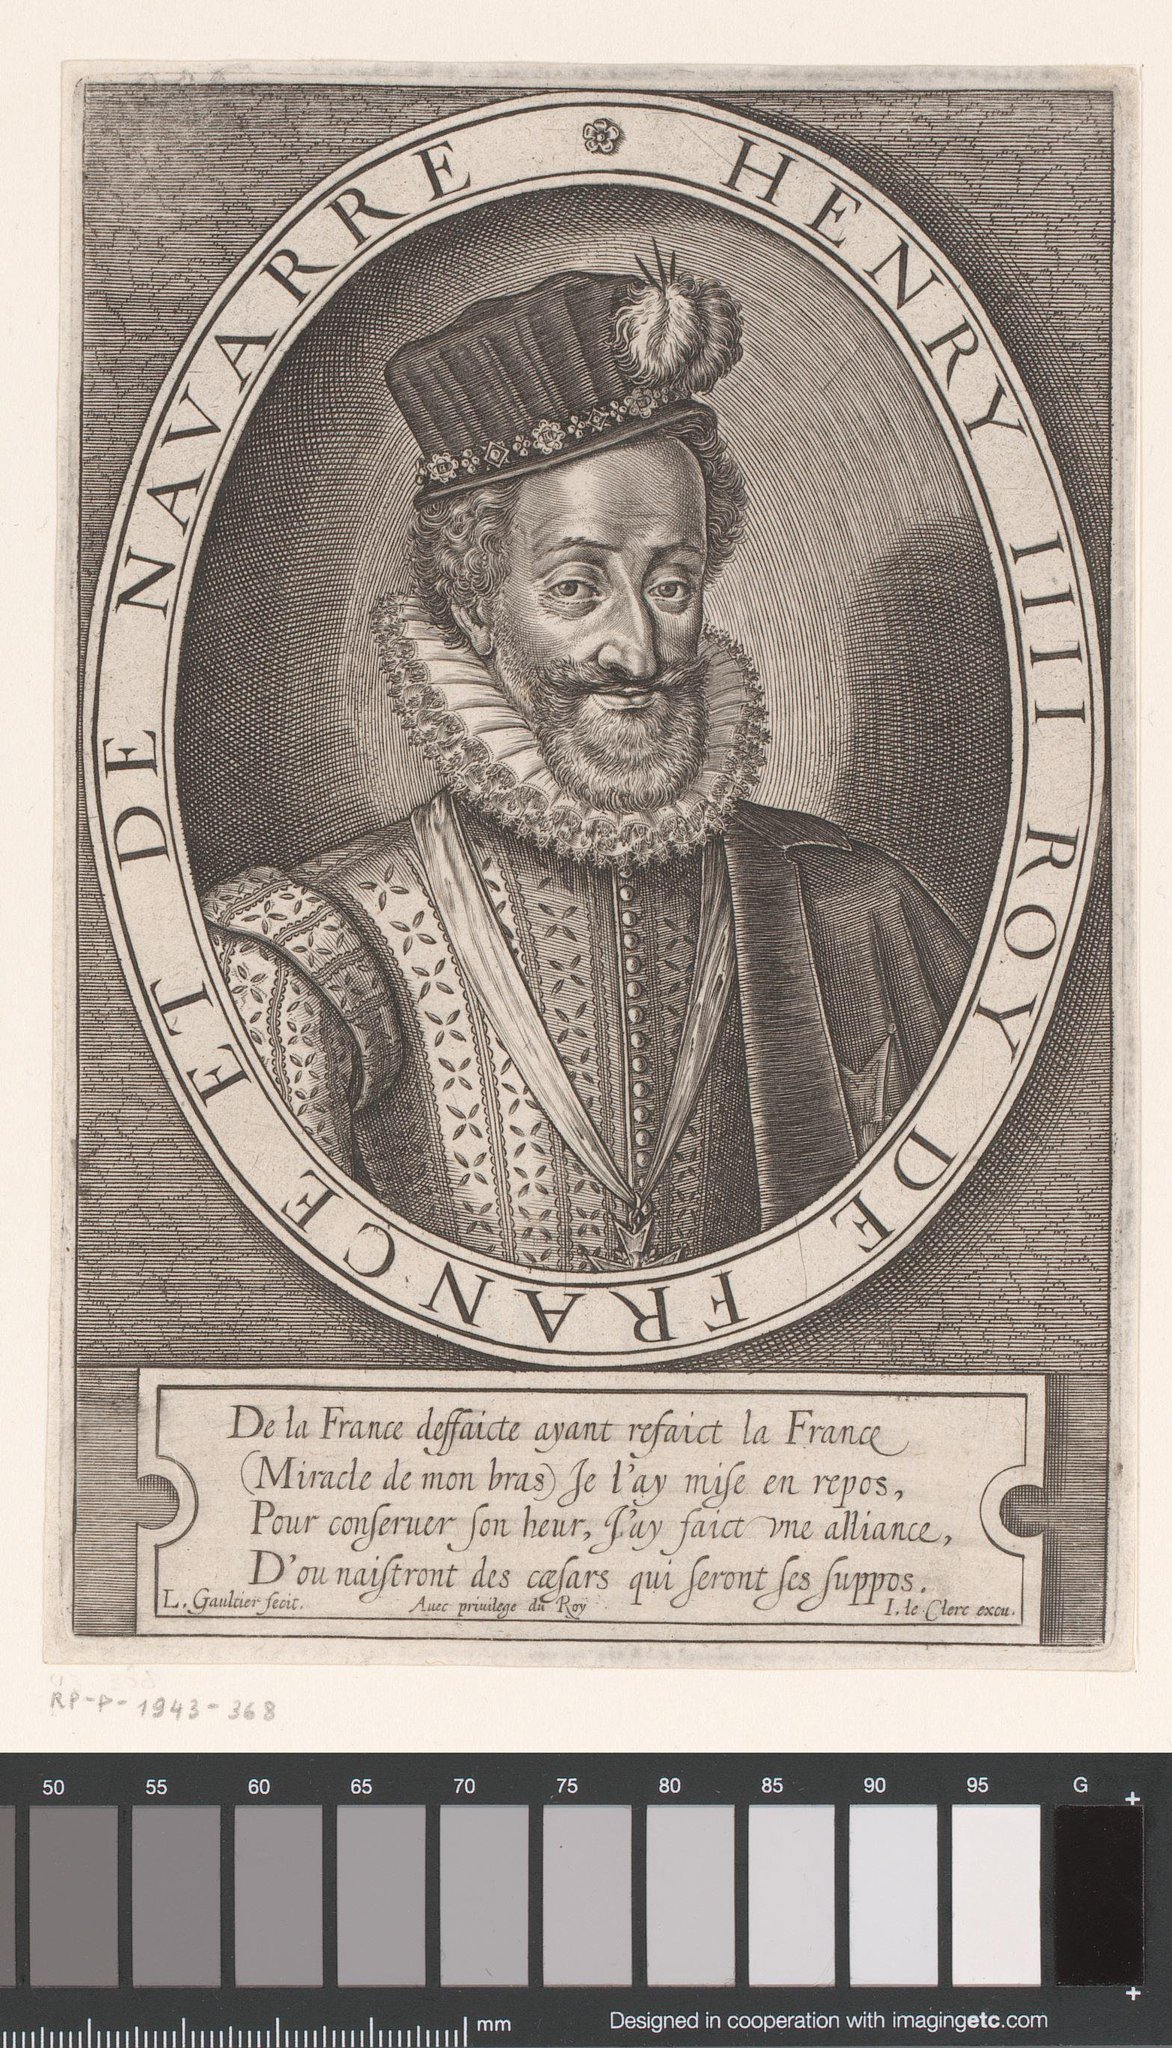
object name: print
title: Portret van Hendrik IV van Frankrijk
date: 1600-1610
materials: paper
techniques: engraving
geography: paris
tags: paris, hendrik iv (koning van frankrijk en navarra), ornament ~ medallion, historical persons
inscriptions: collector's mark: Lugt 2228, collector's mark: Lugt 2760